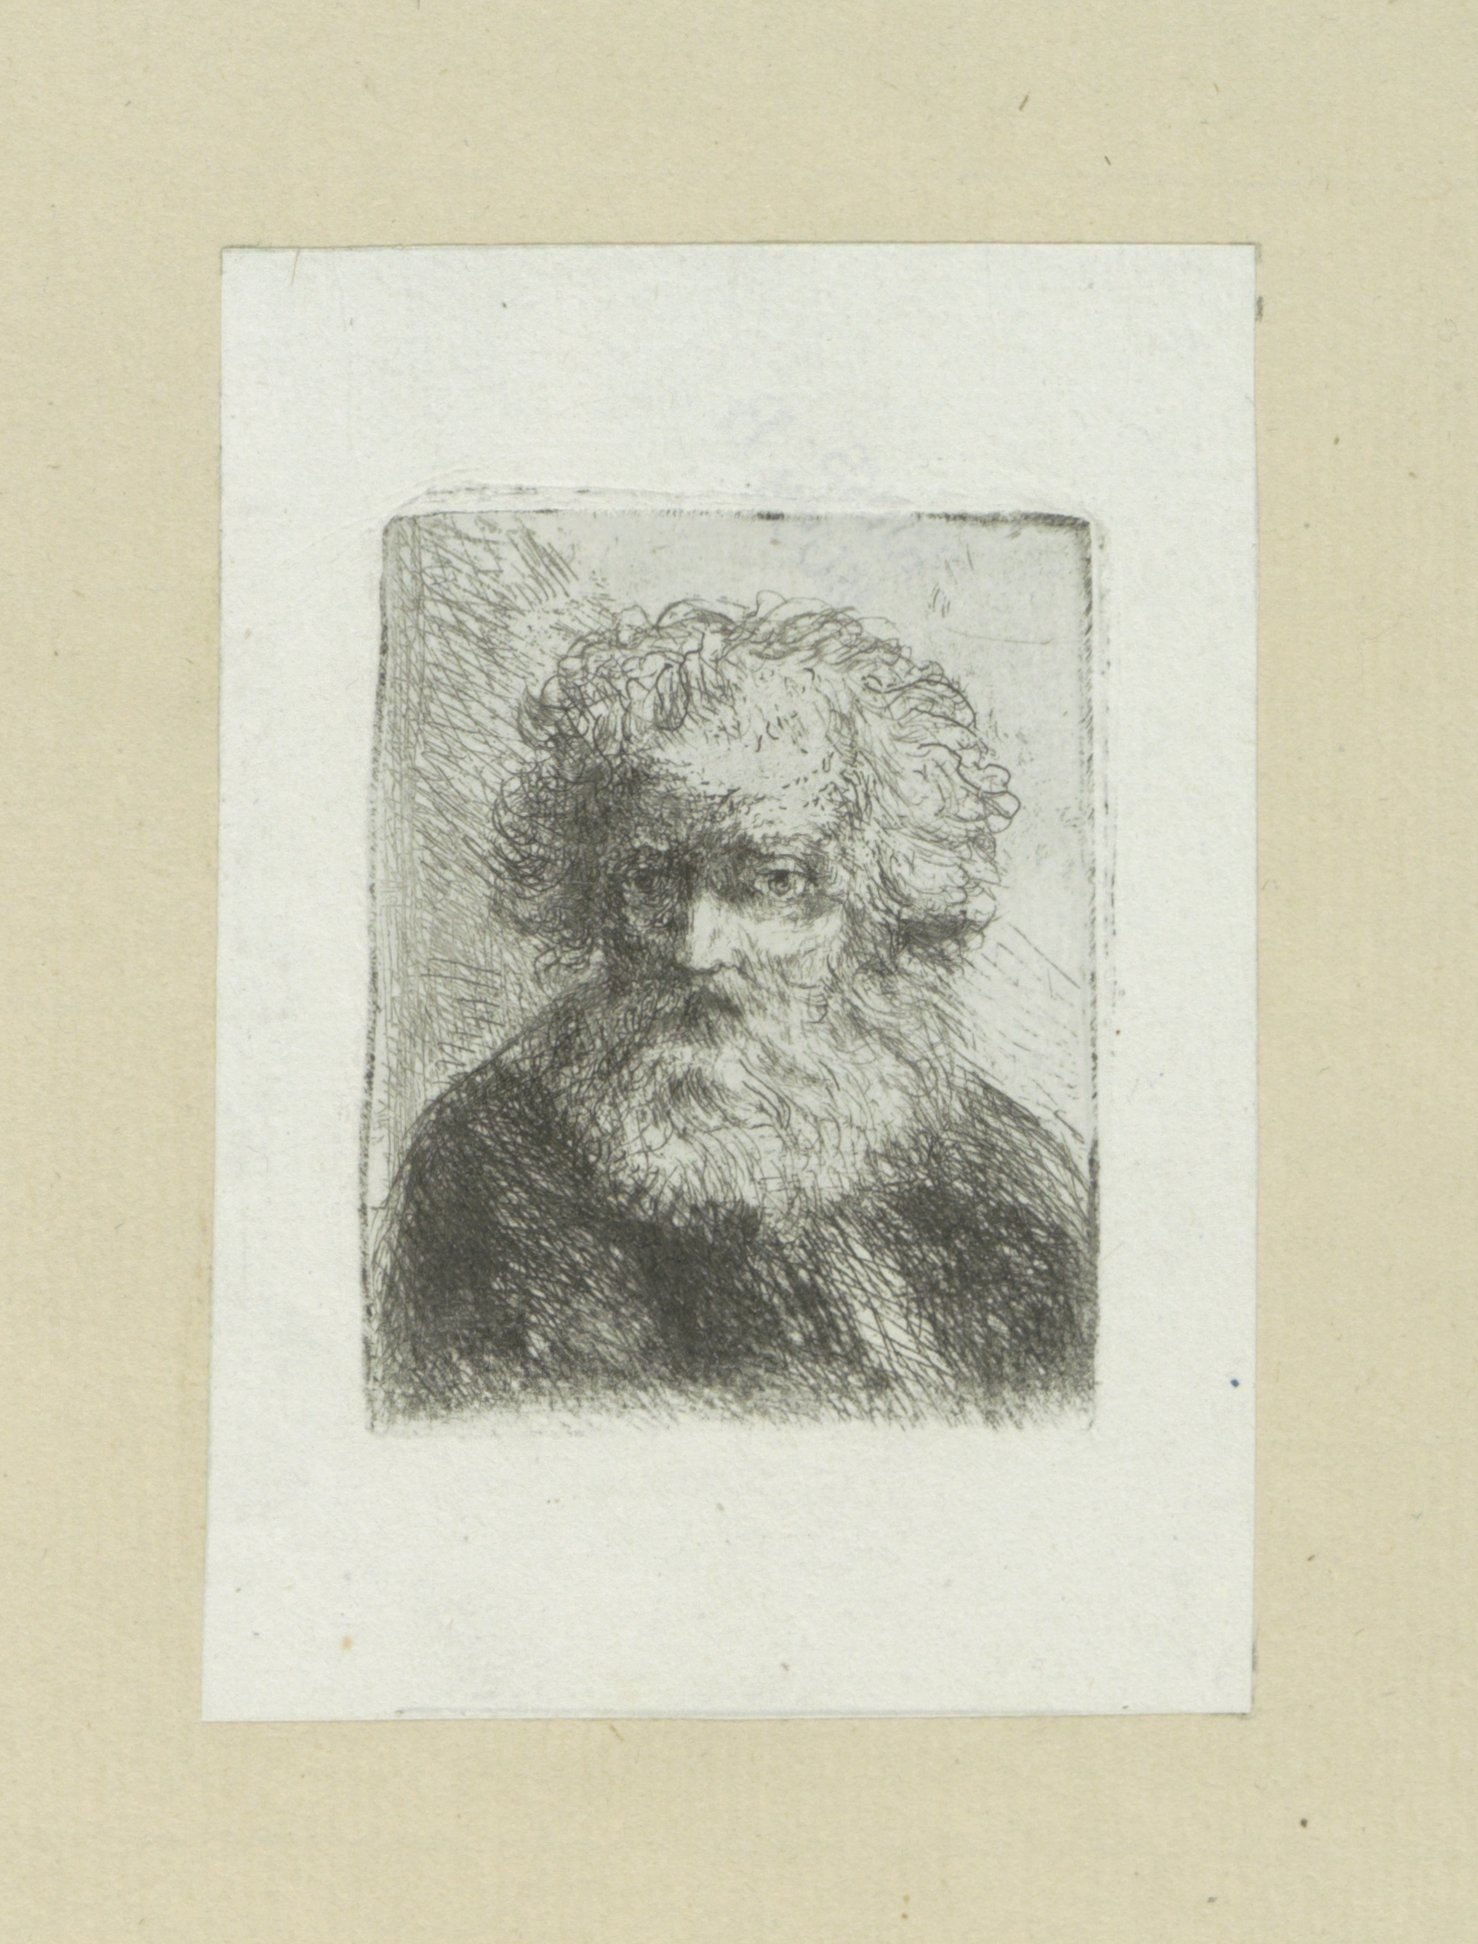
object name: album leaf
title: The Compleat Work of Etchings by John Chalon / Oeuvre Complette des Eaux Fortes par Jean Chalon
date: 1802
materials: paper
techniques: drypoint, etching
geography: london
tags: old man, morphology of human expression (+ old male (human being))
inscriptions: collector's mark: ‘B’, collector's mark: ‘RIJKS / MUSM’